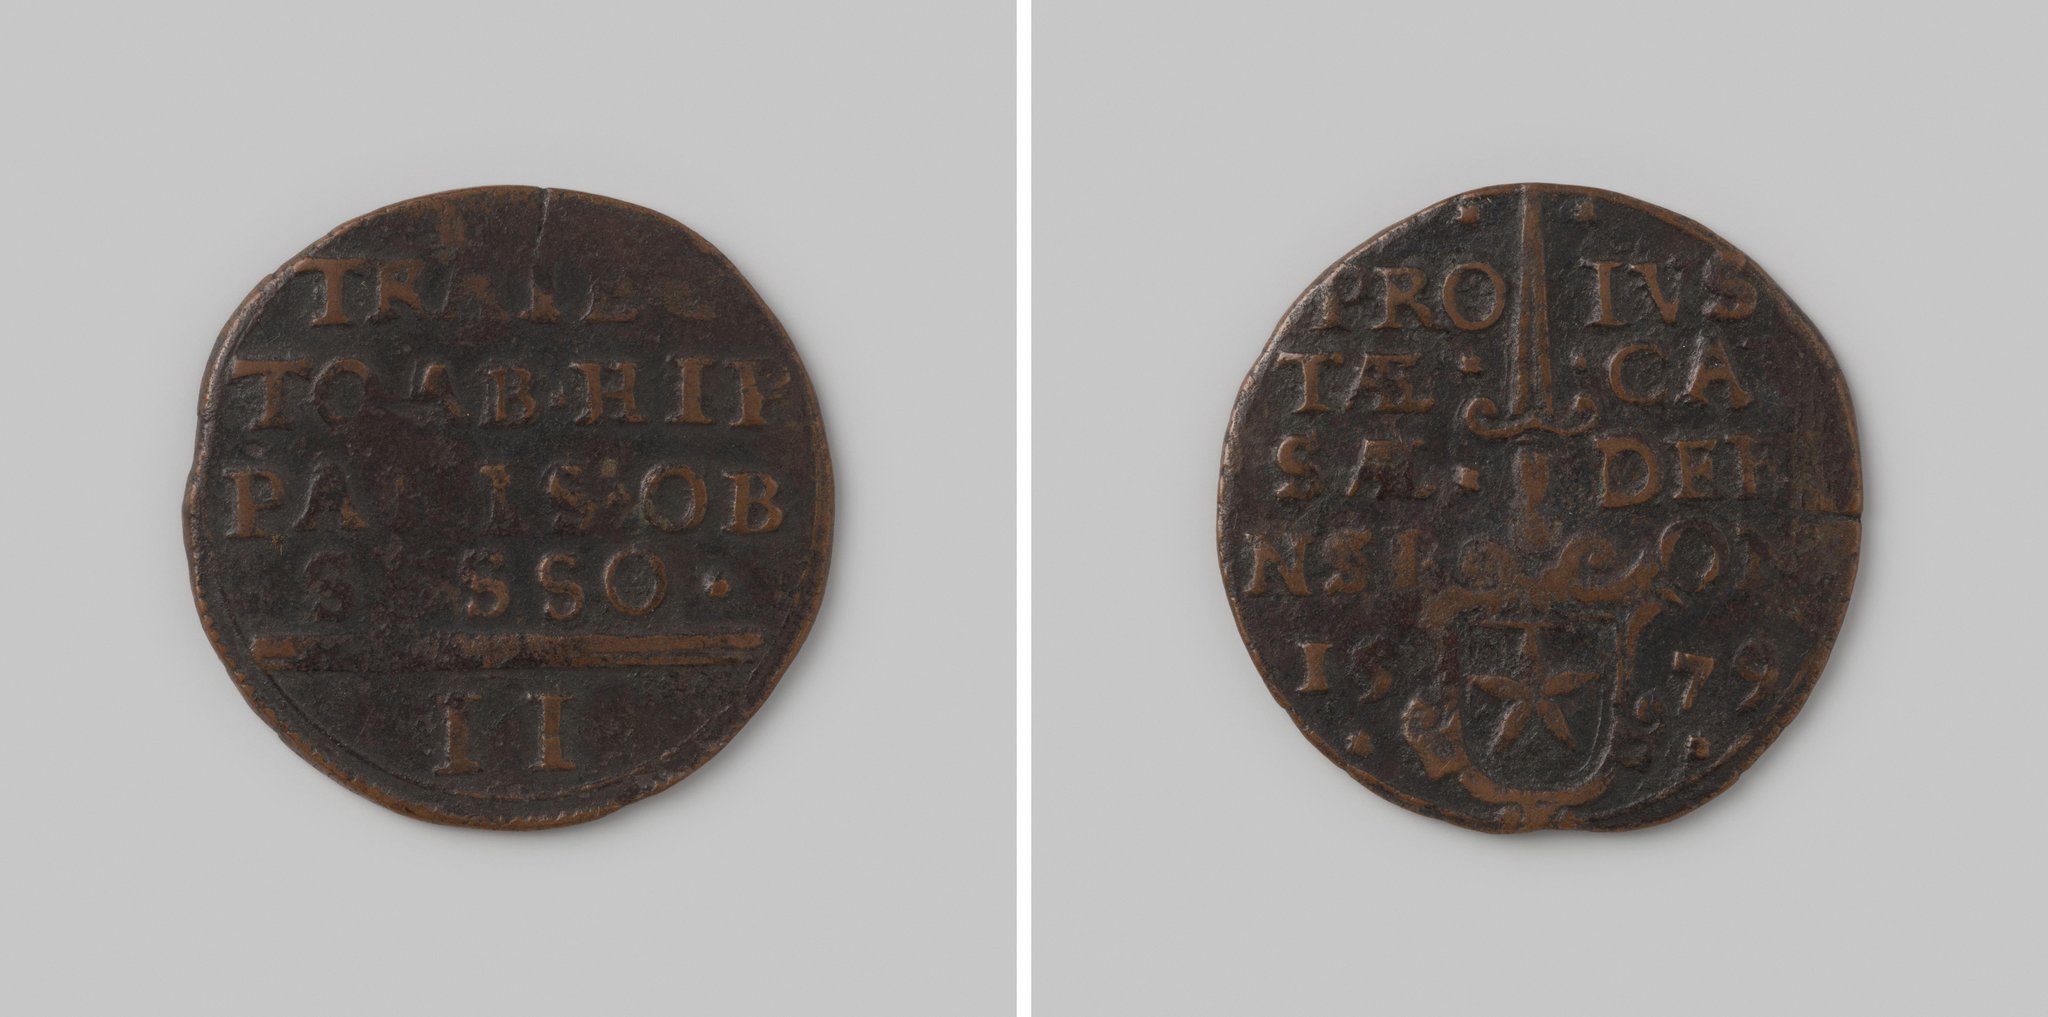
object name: coin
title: Stad Maastricht, noodmunt van 2 stuiver, 1579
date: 1579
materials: copper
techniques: striking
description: Koperen noodmunt. Voorzijde: Opschrift in vier regels: Traiecto ab Hippanis [sic]obsesso. In afsnede waarde-aanduiding. Keerzijde: zwaard boven stadswapen met aan weerszijden vijfregelig opschrift: pro ivstae cavsae defensione met jaatal: 1579.